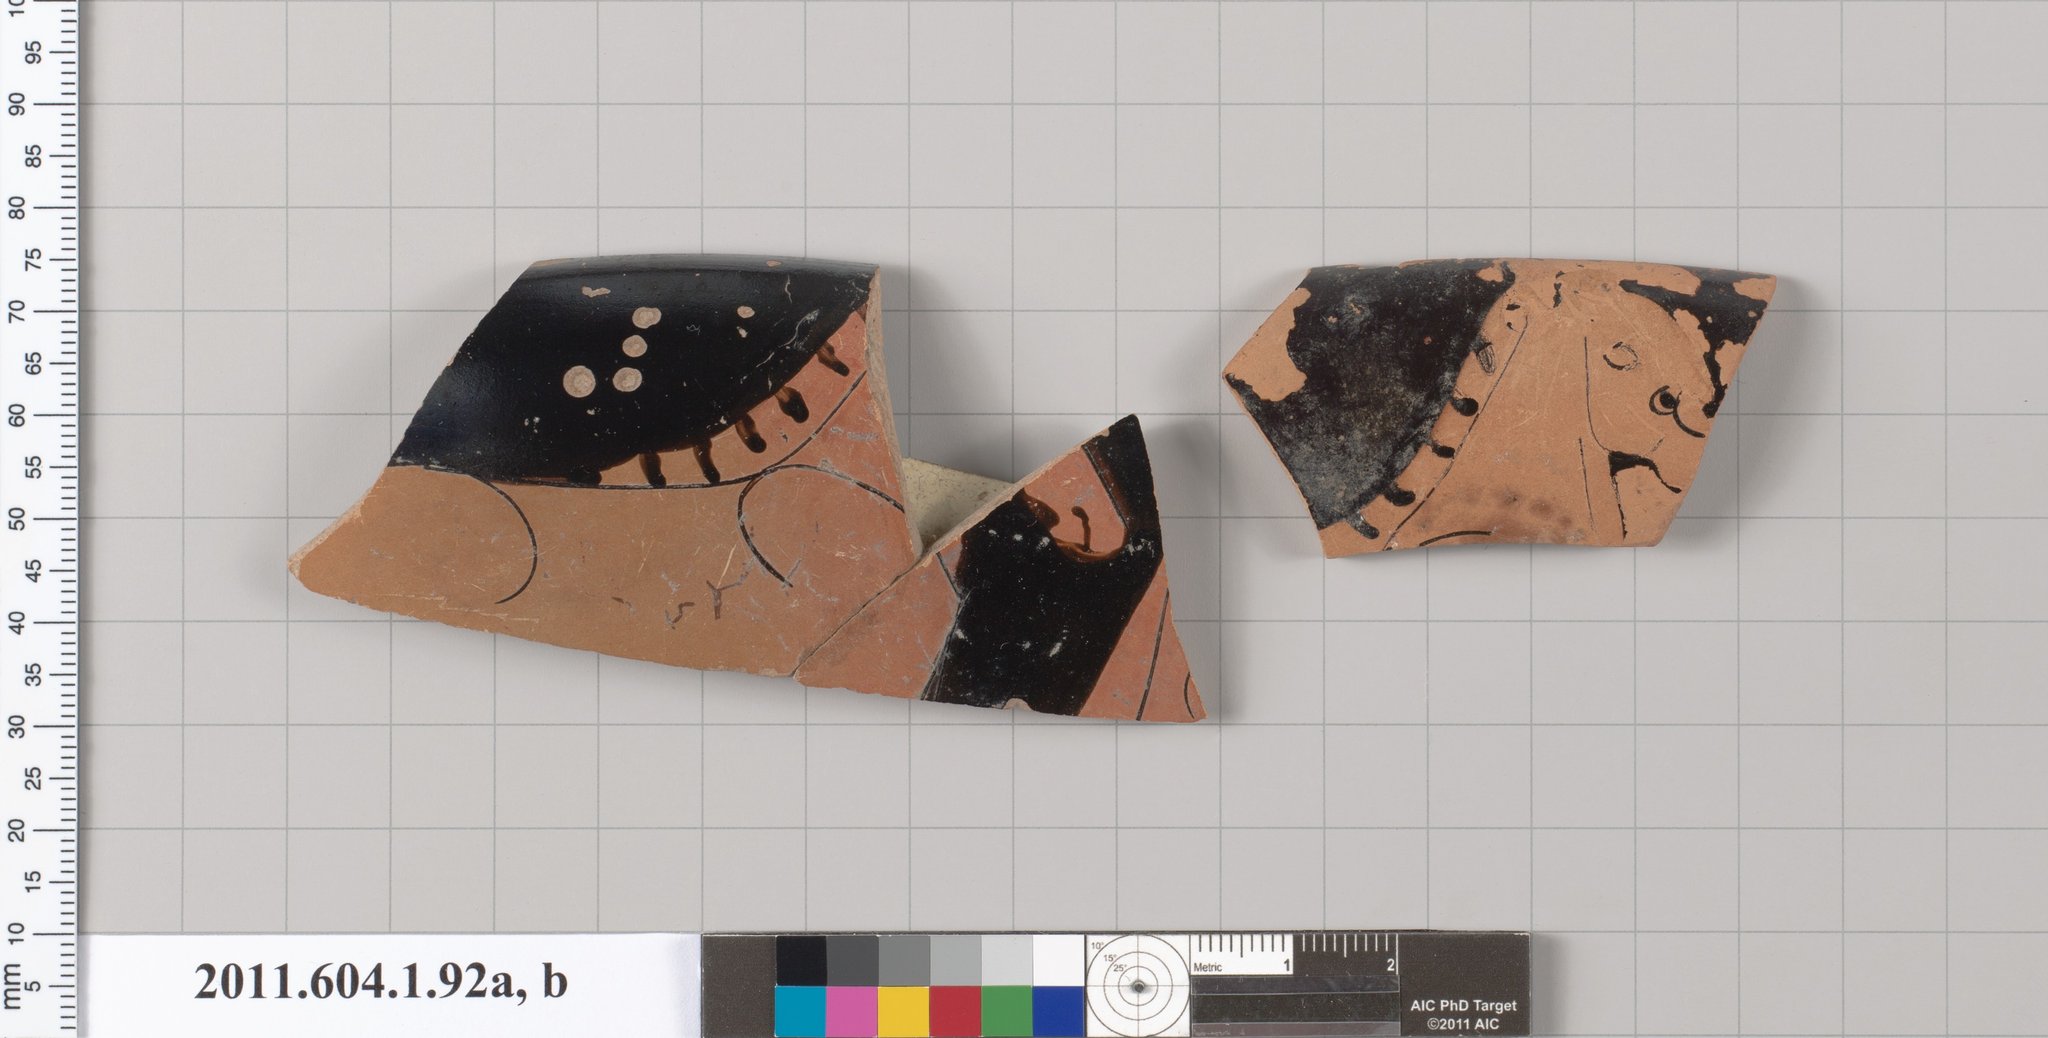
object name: kylix fragment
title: Terracotta rim fragments of a kylix (drinking cup)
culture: greek, attic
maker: painter of london d 12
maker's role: artist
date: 475-451 BCE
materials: terracotta